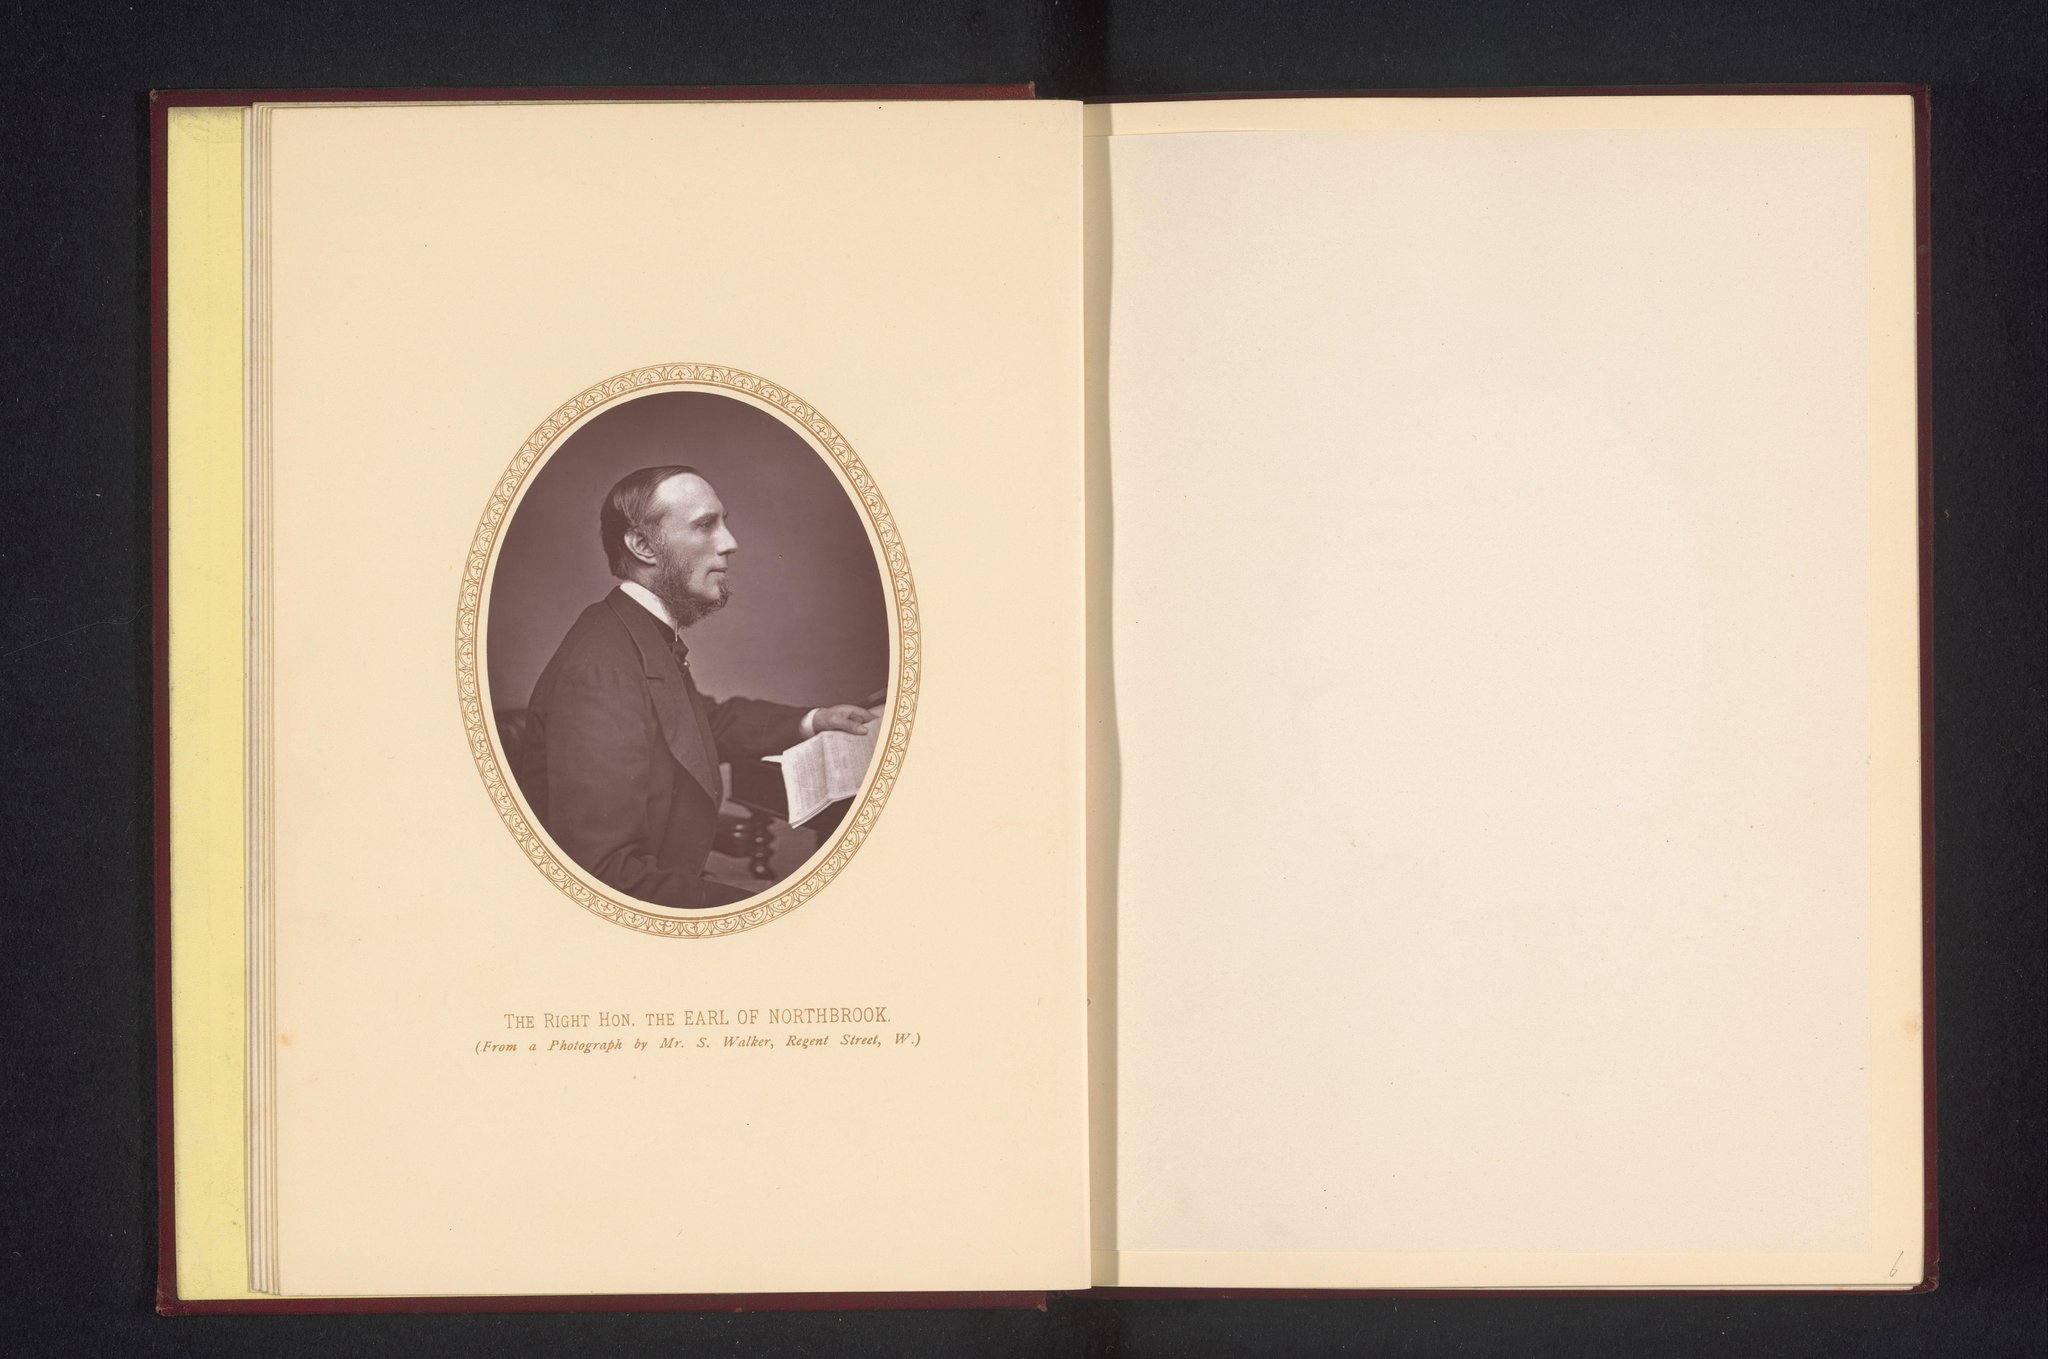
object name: photomechanical print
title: Portret van Thomas Baring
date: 1877-1882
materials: paper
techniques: woodburytype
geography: london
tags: politician, politician, e.g. party leader